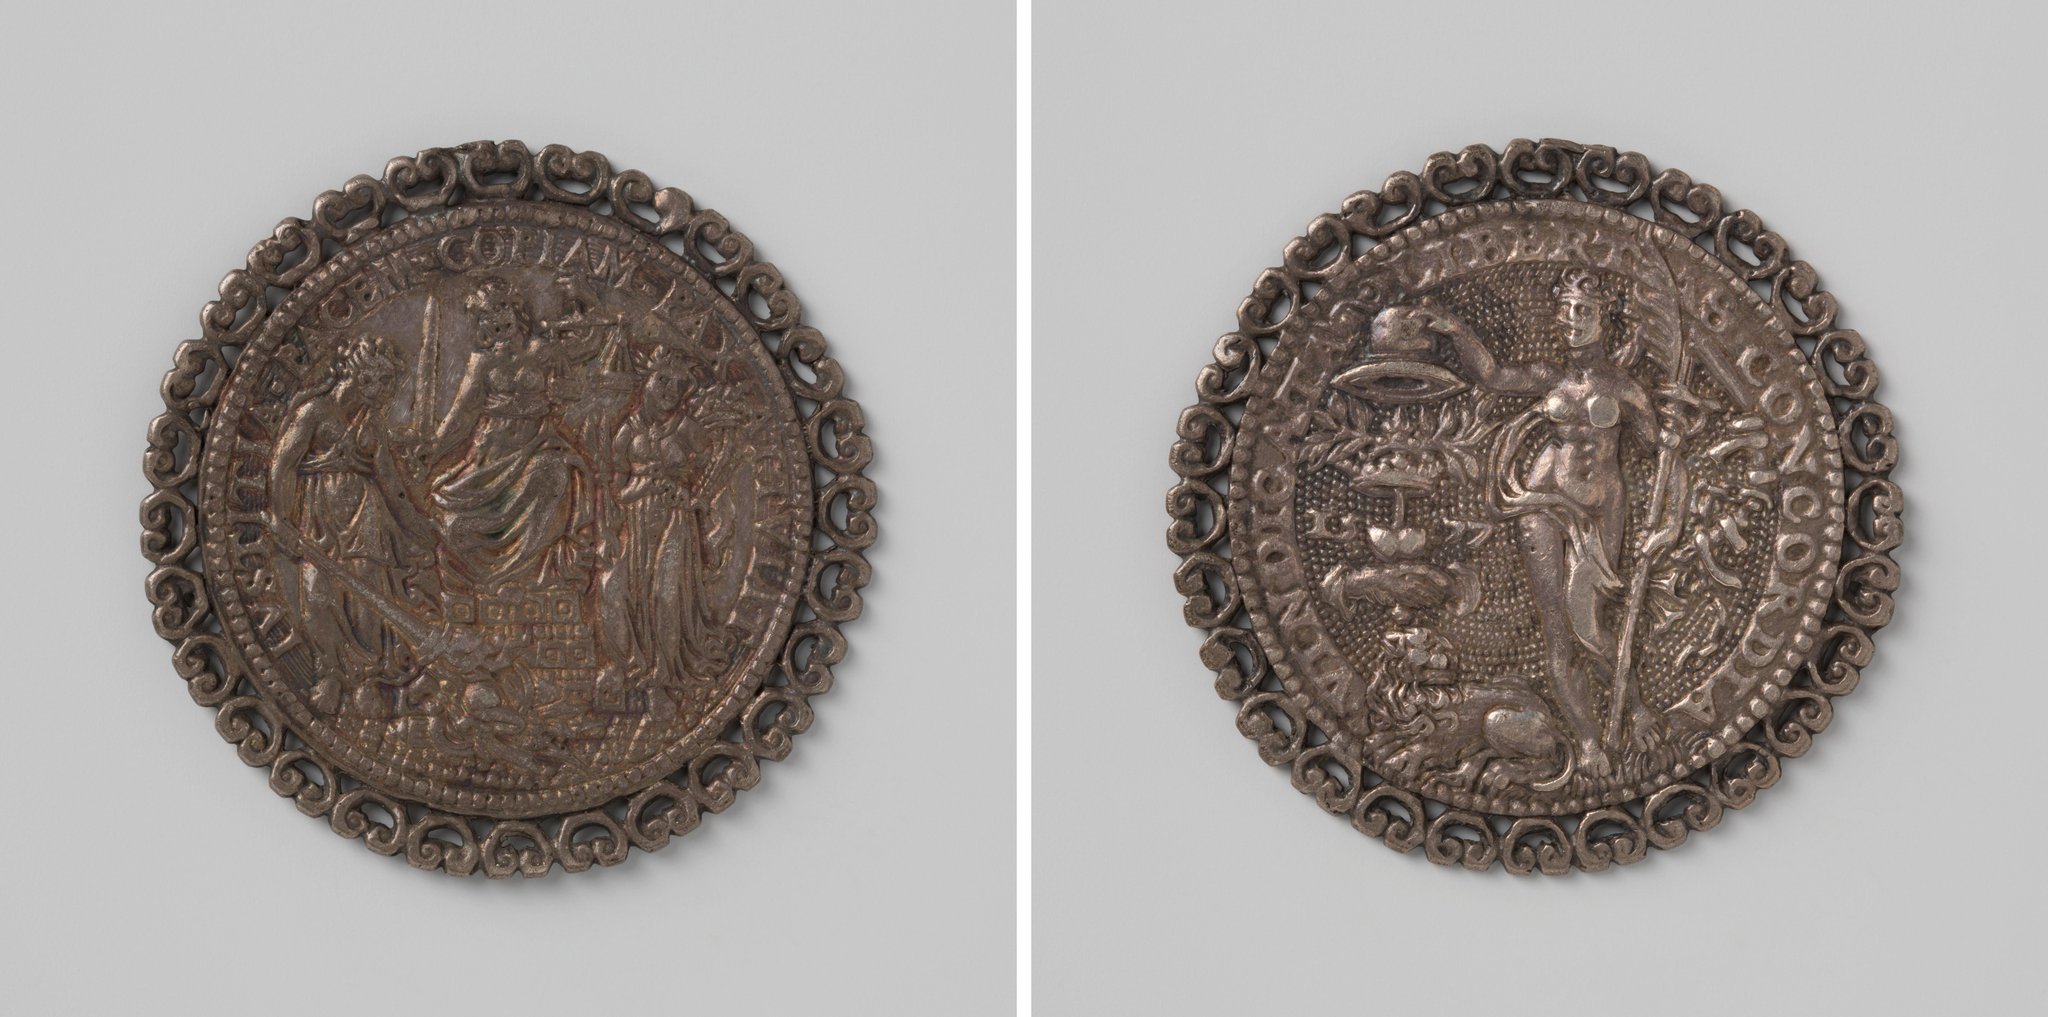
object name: history medal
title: Eeuwig Edict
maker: jacques jonghelinck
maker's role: medailleur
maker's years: 1530-1606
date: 1577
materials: silver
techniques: casting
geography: antwerp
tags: tachtigjarige oorlog, eeuwig edict (1577)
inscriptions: circumscription: ‘IVSTITIA PACEM COPIAM PAX ATTVLIT’, circumscription: ‘VINDICATA LIBERTAS CONCORDIA / 1577’